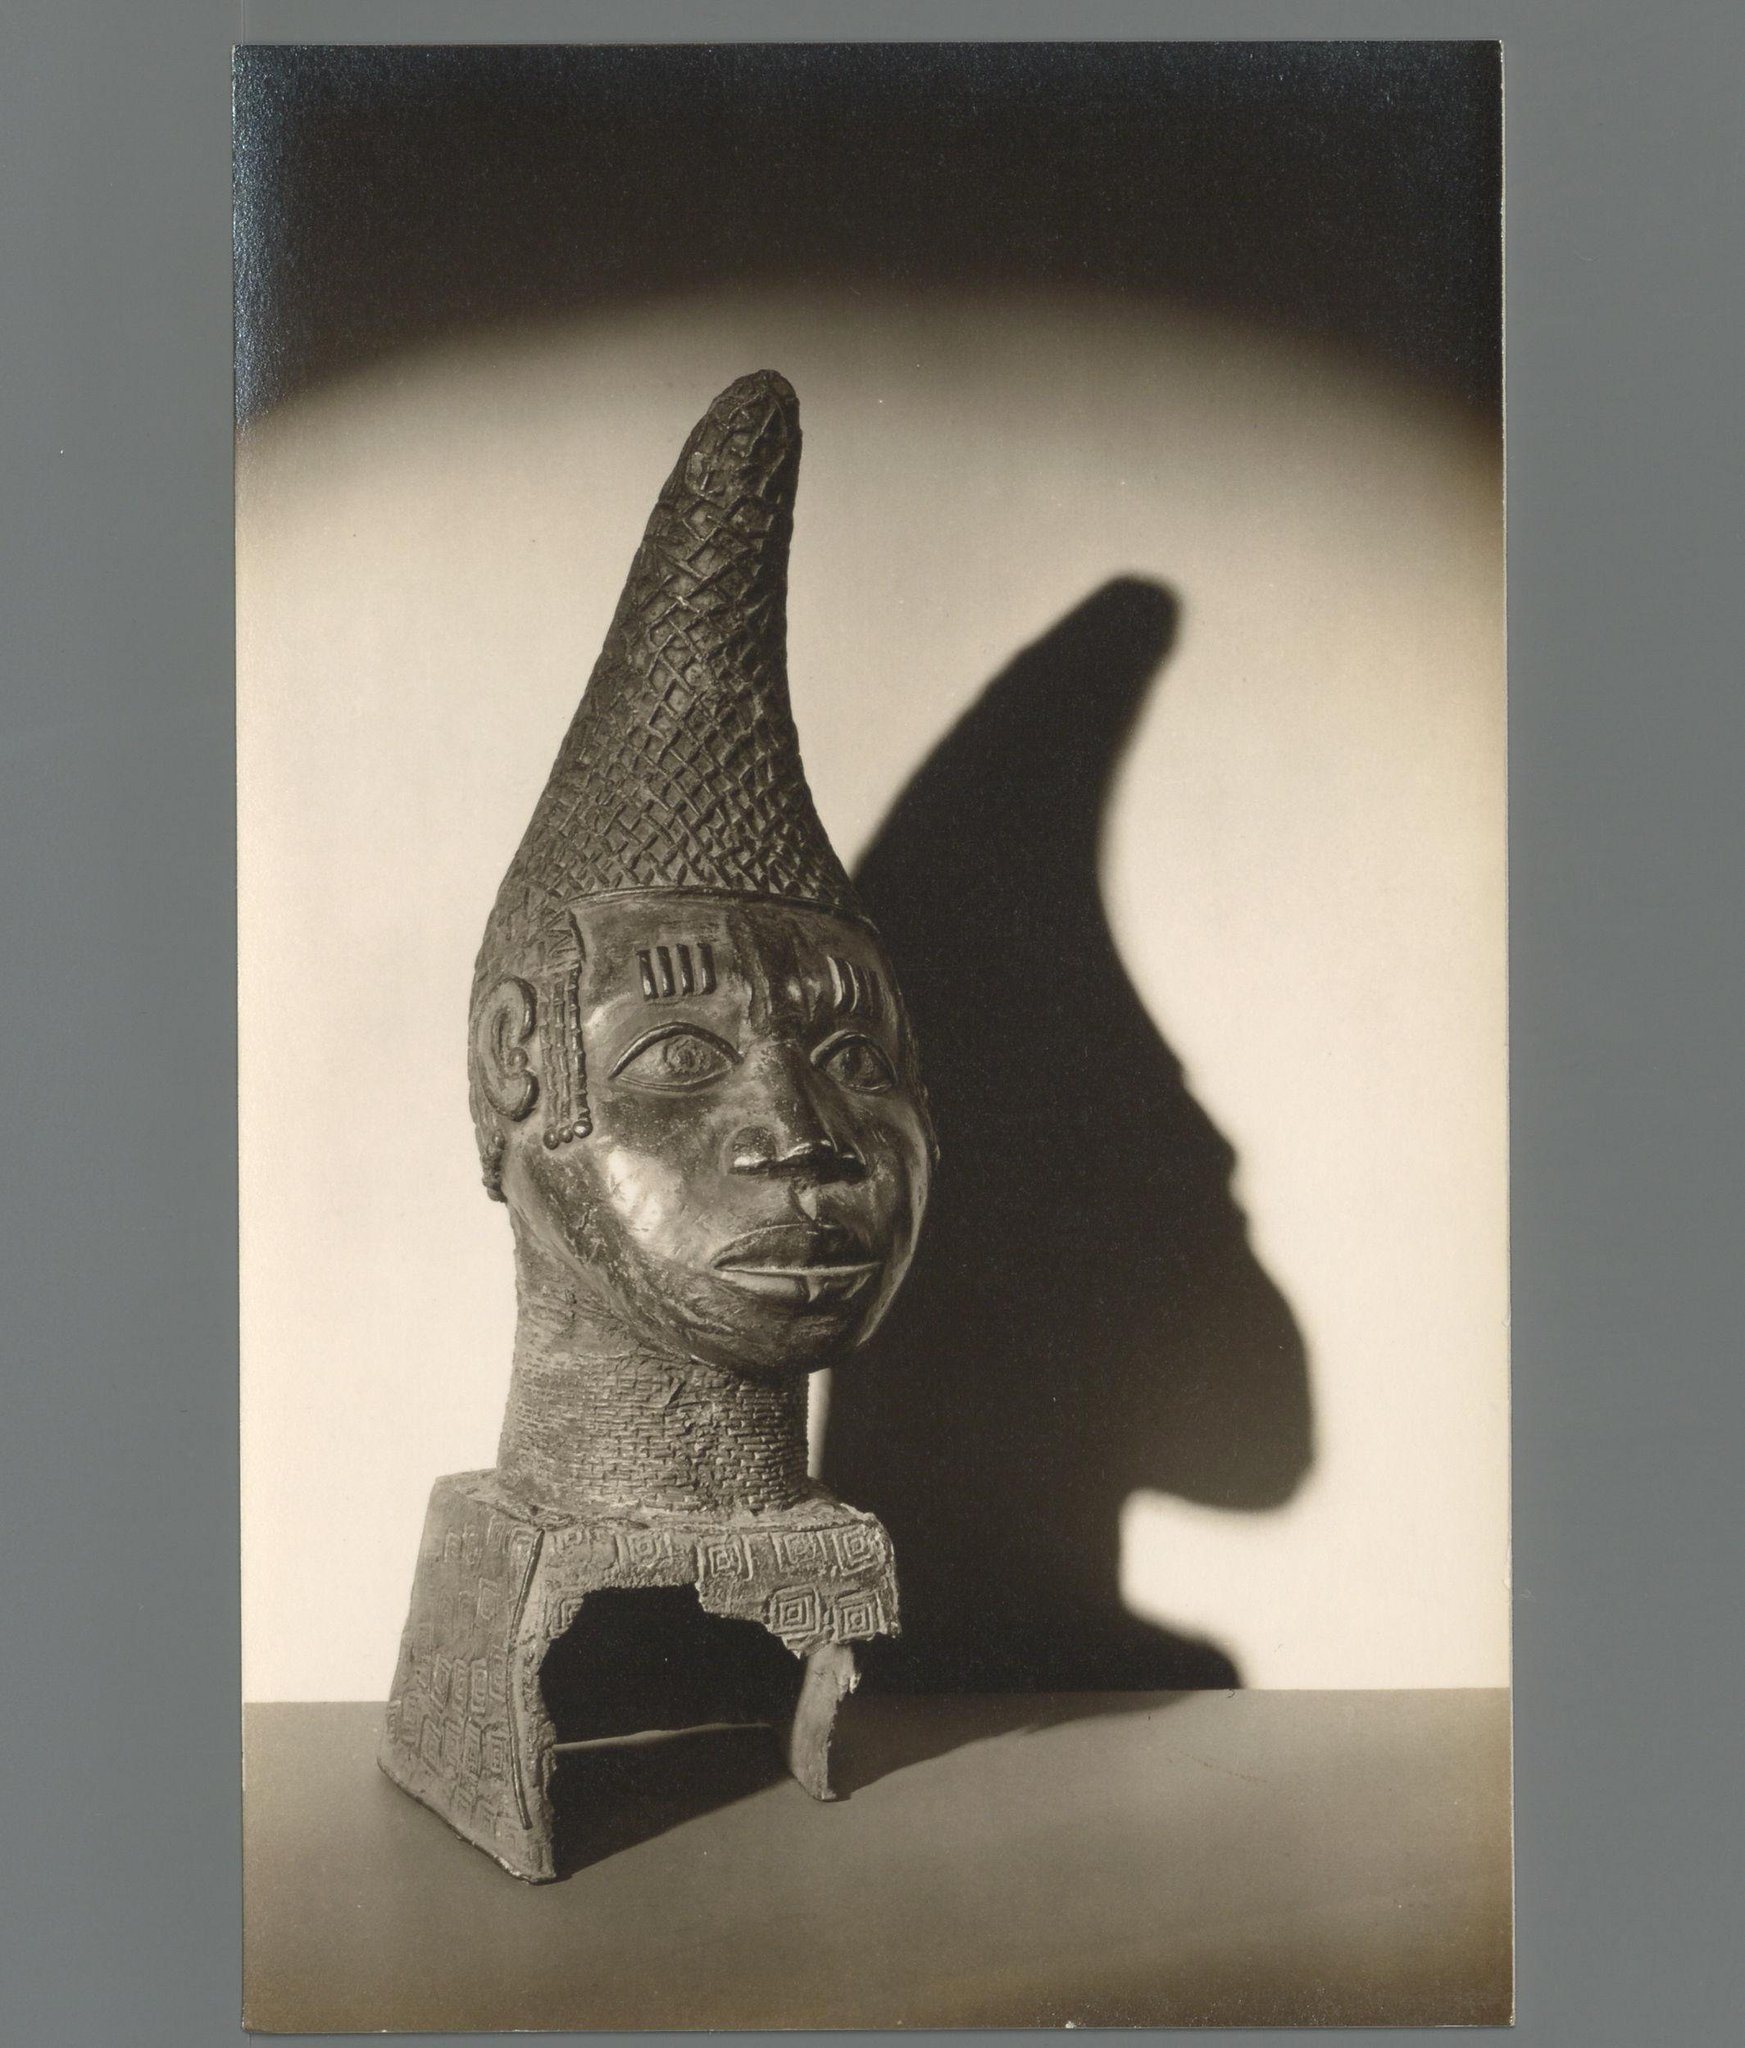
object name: photograph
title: Sculptuur van een mannenhoofd met puntmuts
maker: Anonymous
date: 1920-1940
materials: photographic support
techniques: photography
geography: philadelphia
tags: head (human) (+ three-quarter view), head-gear: hat, sculpture